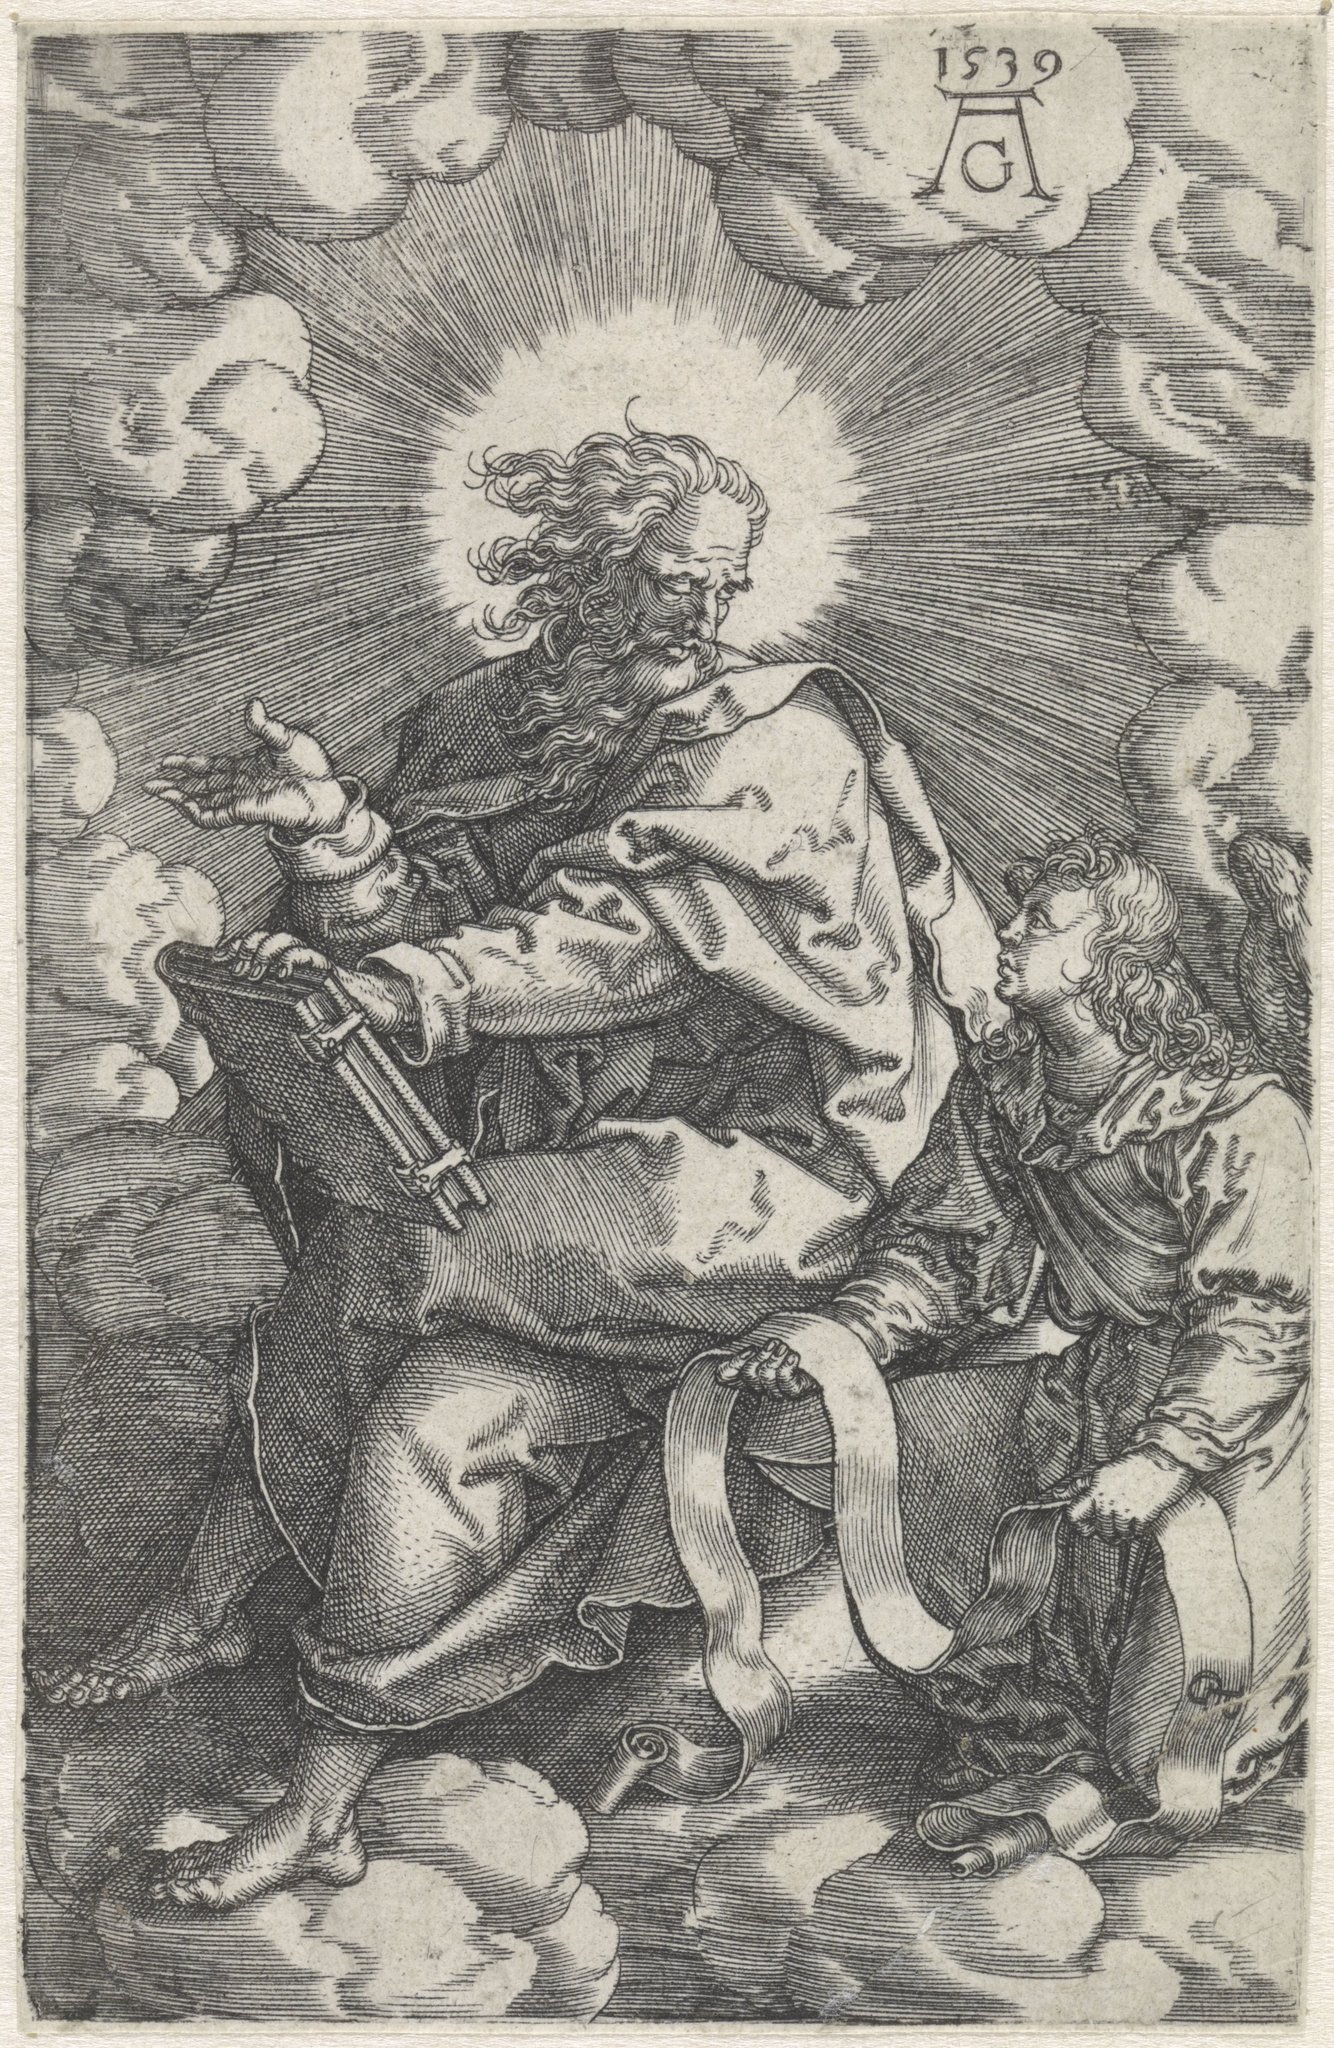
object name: print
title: Mattheüs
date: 1539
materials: paper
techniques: engraving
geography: germany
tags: the apostle and evangelist matthew (mattheus); possible attributes: angel, axe, book, halberd, pen and inkhorn, purse, scroll, square, sword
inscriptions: date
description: Mattheüs de evangelist zittend op een wolk, het evangelie in zijn linkerhand, links van hem de engel met een banderol in de handen.